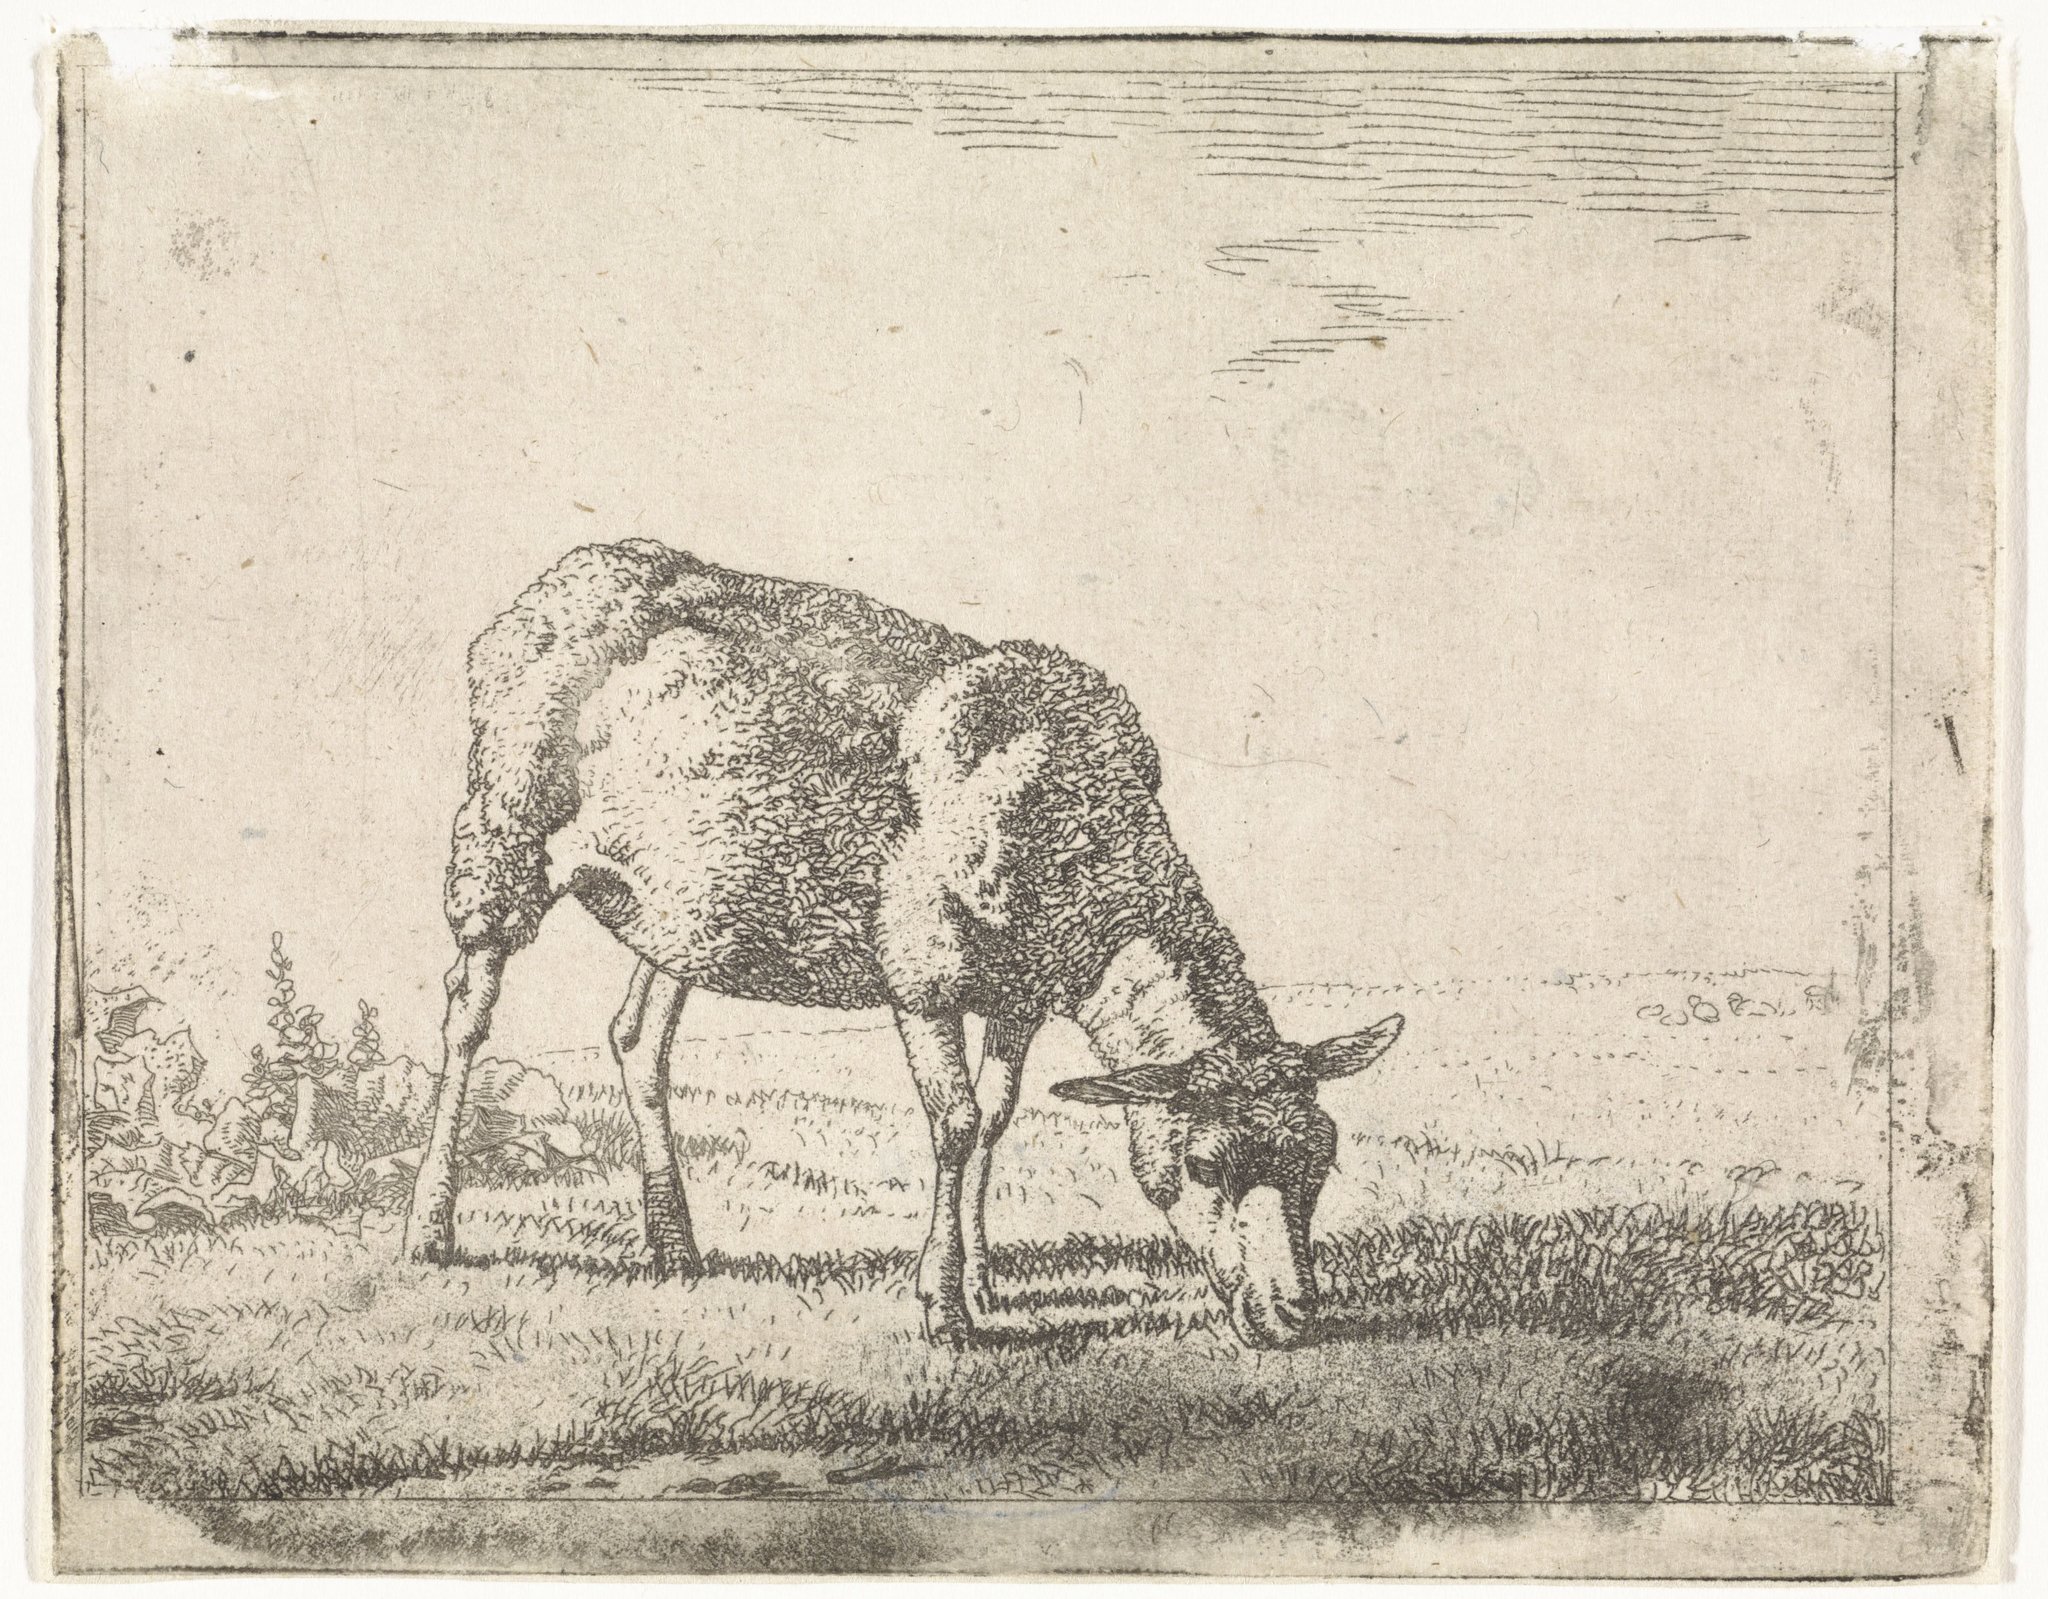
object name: print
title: Grazend schaap naar rechts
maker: wouter johannes van troostwijk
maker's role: draughtsman, painter, print maker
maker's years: 1782-1810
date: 1792-1810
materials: paper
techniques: etching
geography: amsterdam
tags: sheep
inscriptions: collector's mark: Lugt 2228